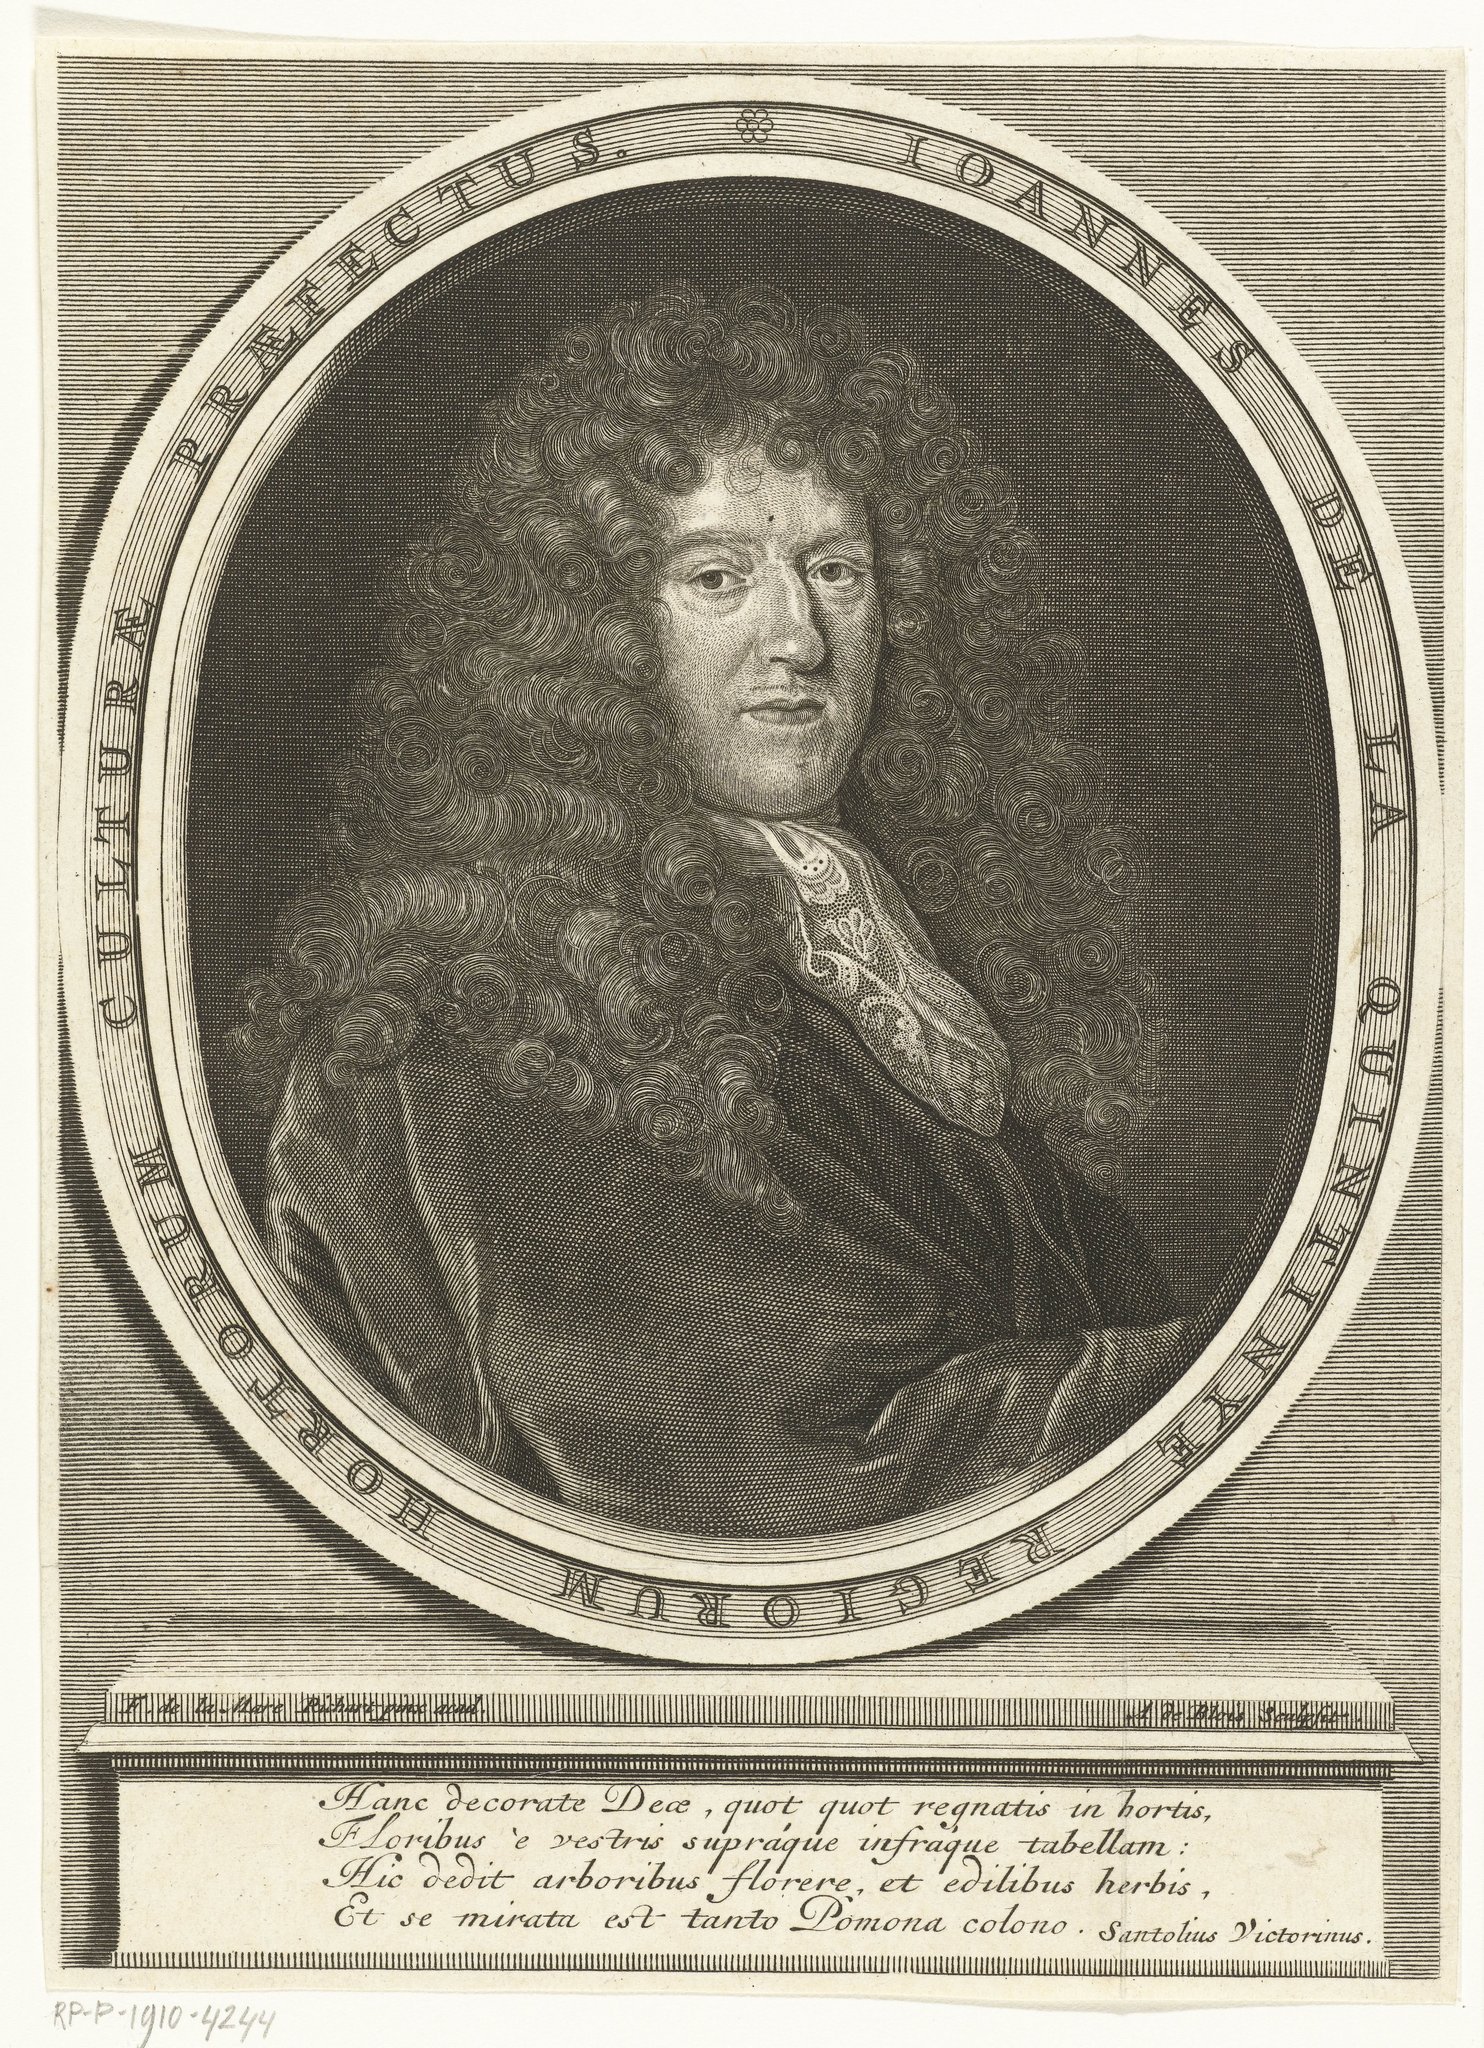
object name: print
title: Ioannes de la Quintinye regiorum hortorum culturae praefectus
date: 1679-1717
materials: paper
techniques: engraving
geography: amsterdam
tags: portrait, self-portrait of architect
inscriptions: collector's mark: Lugt 2228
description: Portret van botanicus Jean-Baptiste de La Quintinie, buste in ovale omlijsting met Latijns vers op voet over zijn kwaliteiten als tuinarchitect en botanicus.